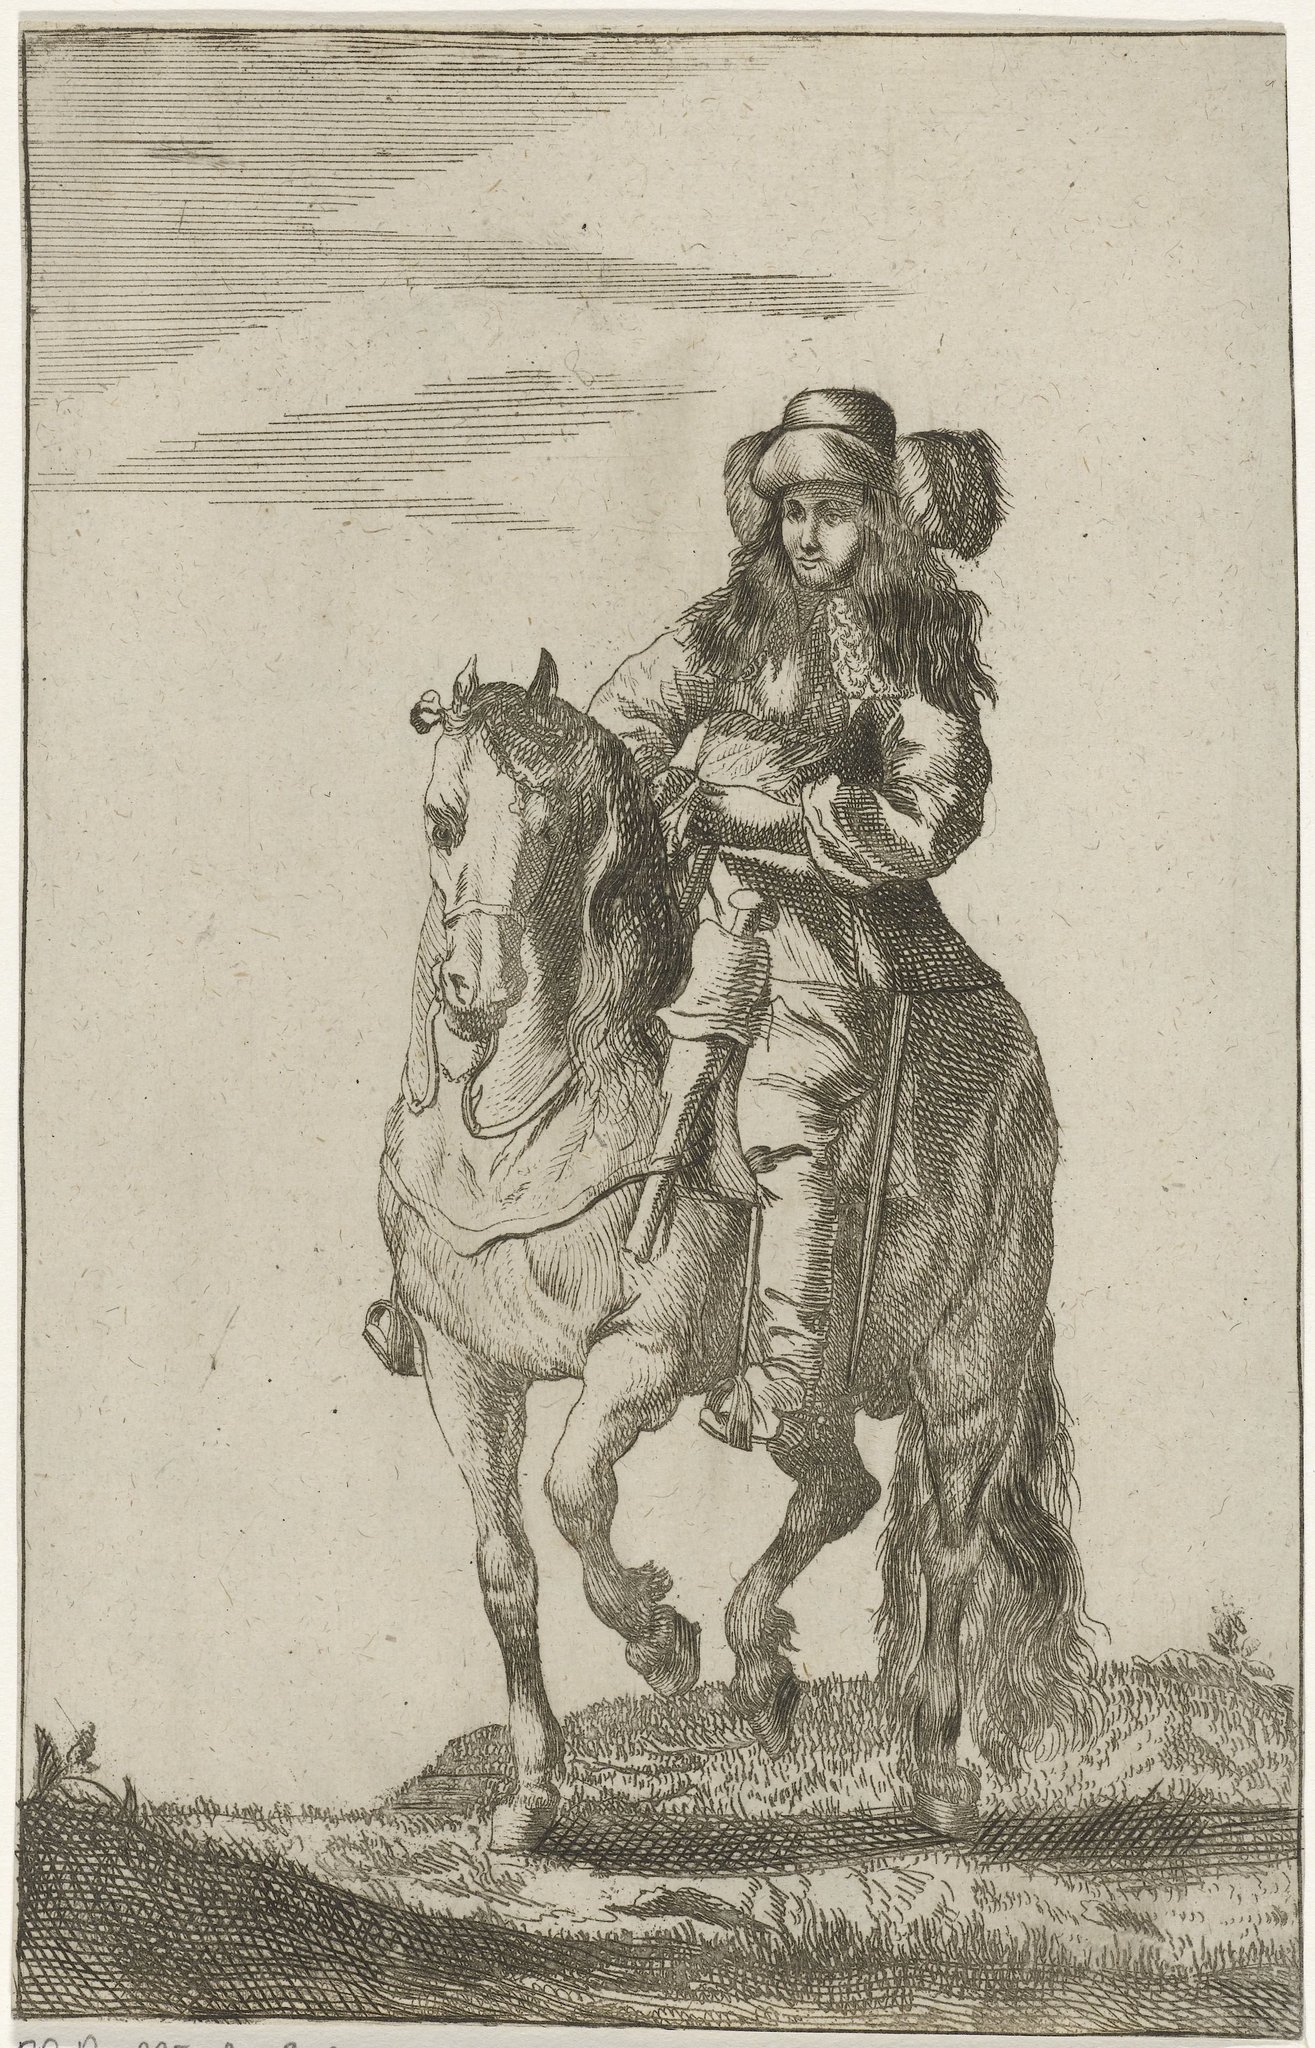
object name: print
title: Ruiter van voren gezien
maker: Anonymous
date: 1623-1703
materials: paper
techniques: engraving, etching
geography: northern netherlands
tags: riding a horse, ass, or mule; rider, horseman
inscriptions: collector's mark: Lugt 2228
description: Een ruiter van voren gezien. Hij draagt een hoed en een sabel aan zijn zij.